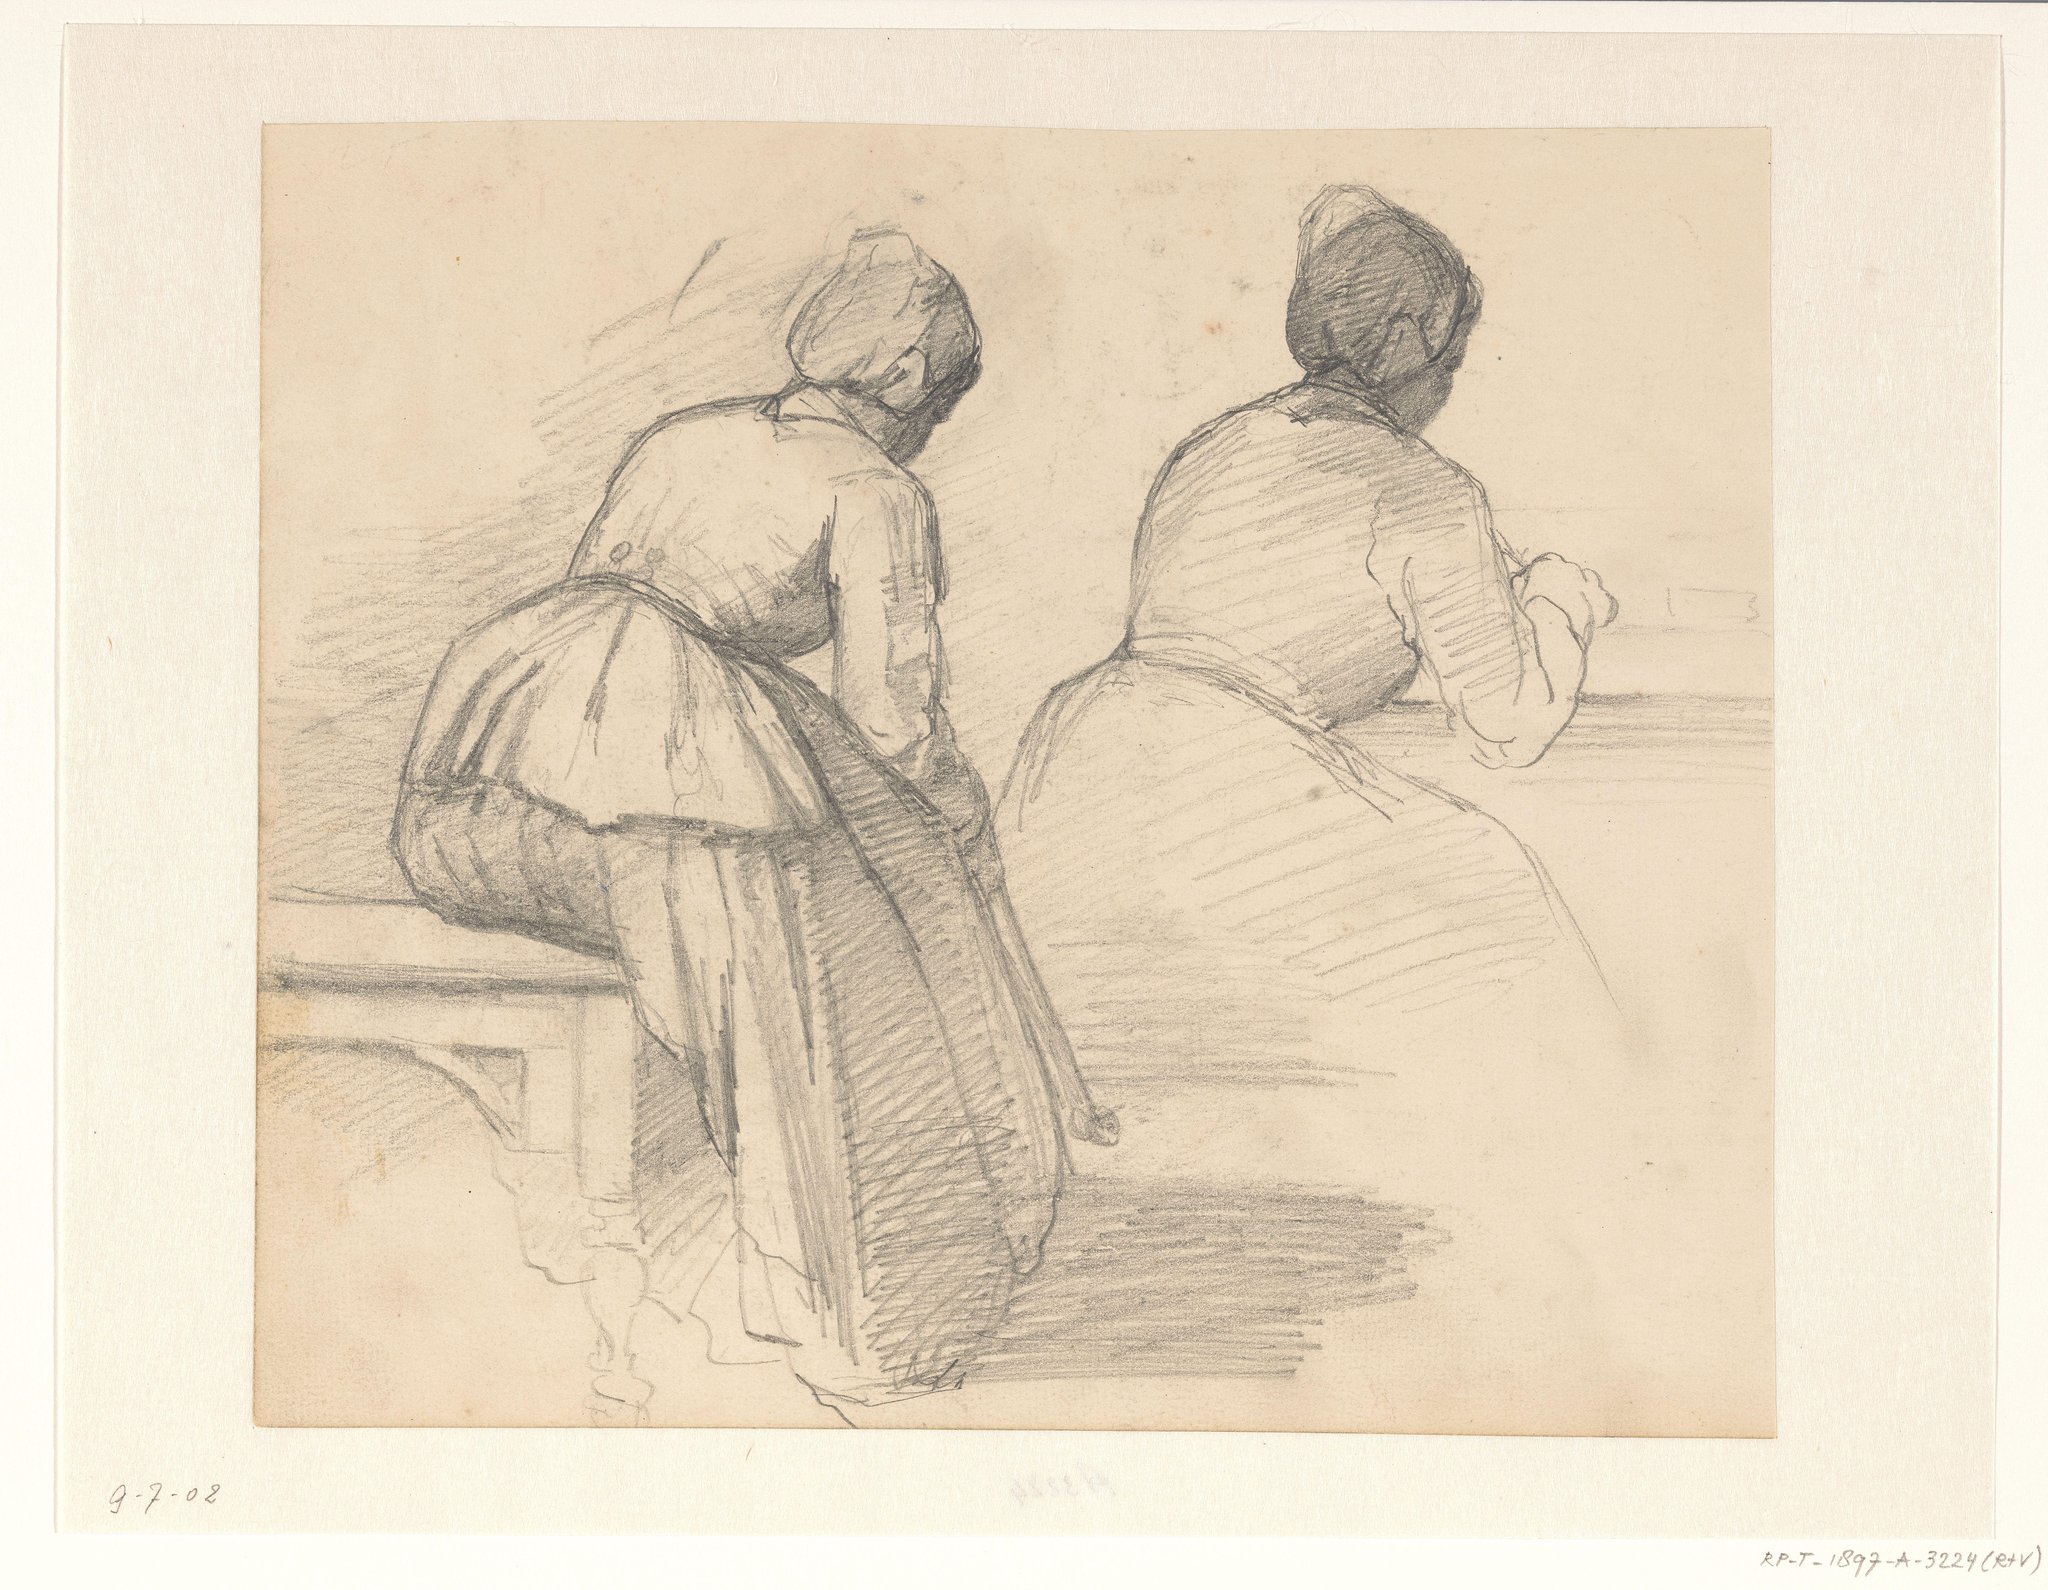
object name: drawing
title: Twee studies van een zittende vrouw, op de rug gezien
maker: hendrik valkenburg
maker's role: draughtsman, painter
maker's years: 1826-1896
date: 1836-1896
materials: paper, pencil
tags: adult woman, interior of the house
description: Twee studies van een zittende vrouw, op de rug gezien.